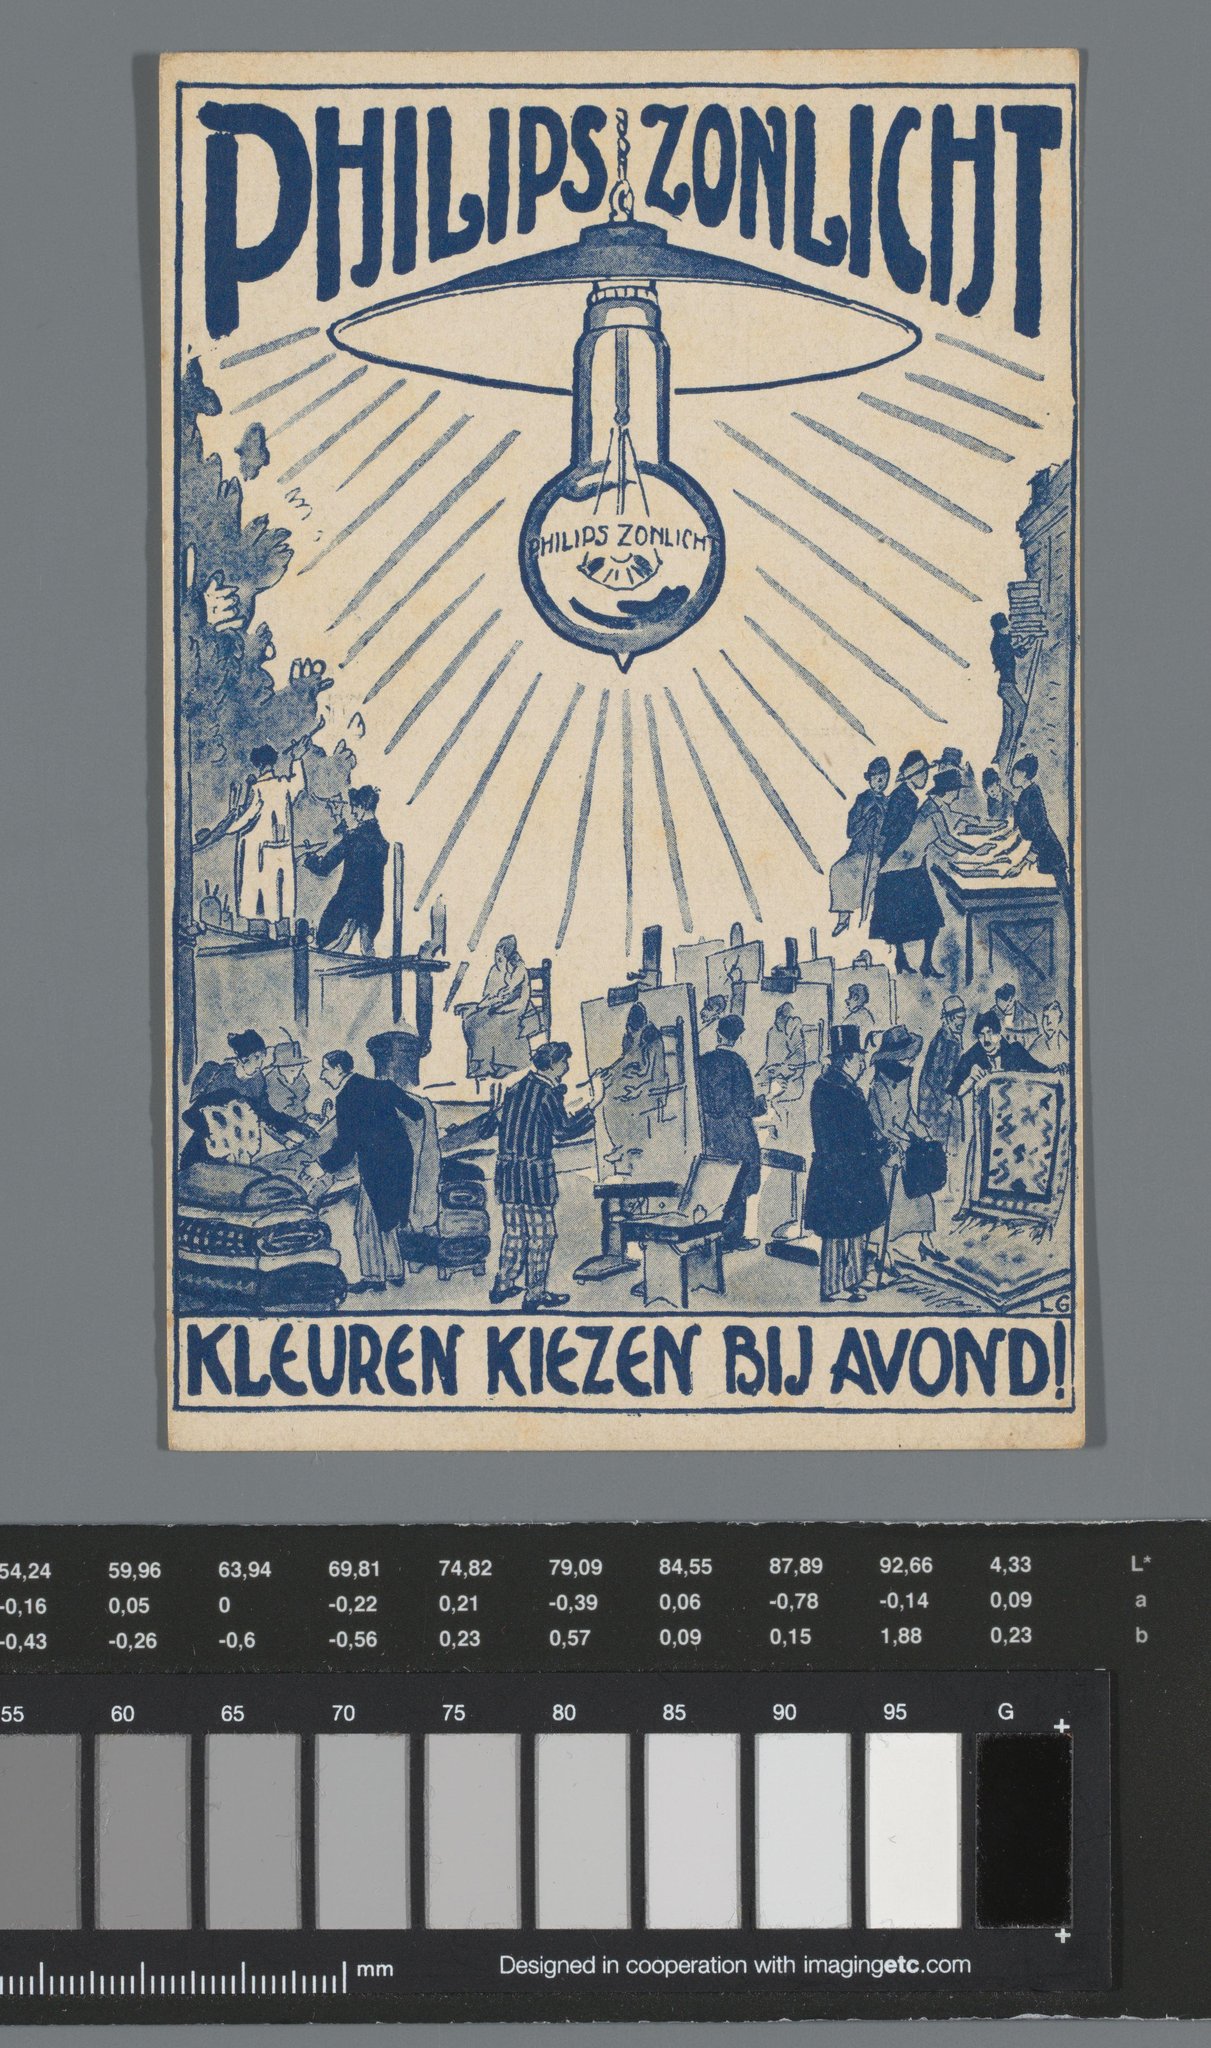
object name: ansichtkaart, prentbriefkaart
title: Philips zonlicht. Kleuren kiezen bij avond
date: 1918-1919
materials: cardboard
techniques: printing block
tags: artist at work, in his workshop, electric lamp, textile fabric, cloth